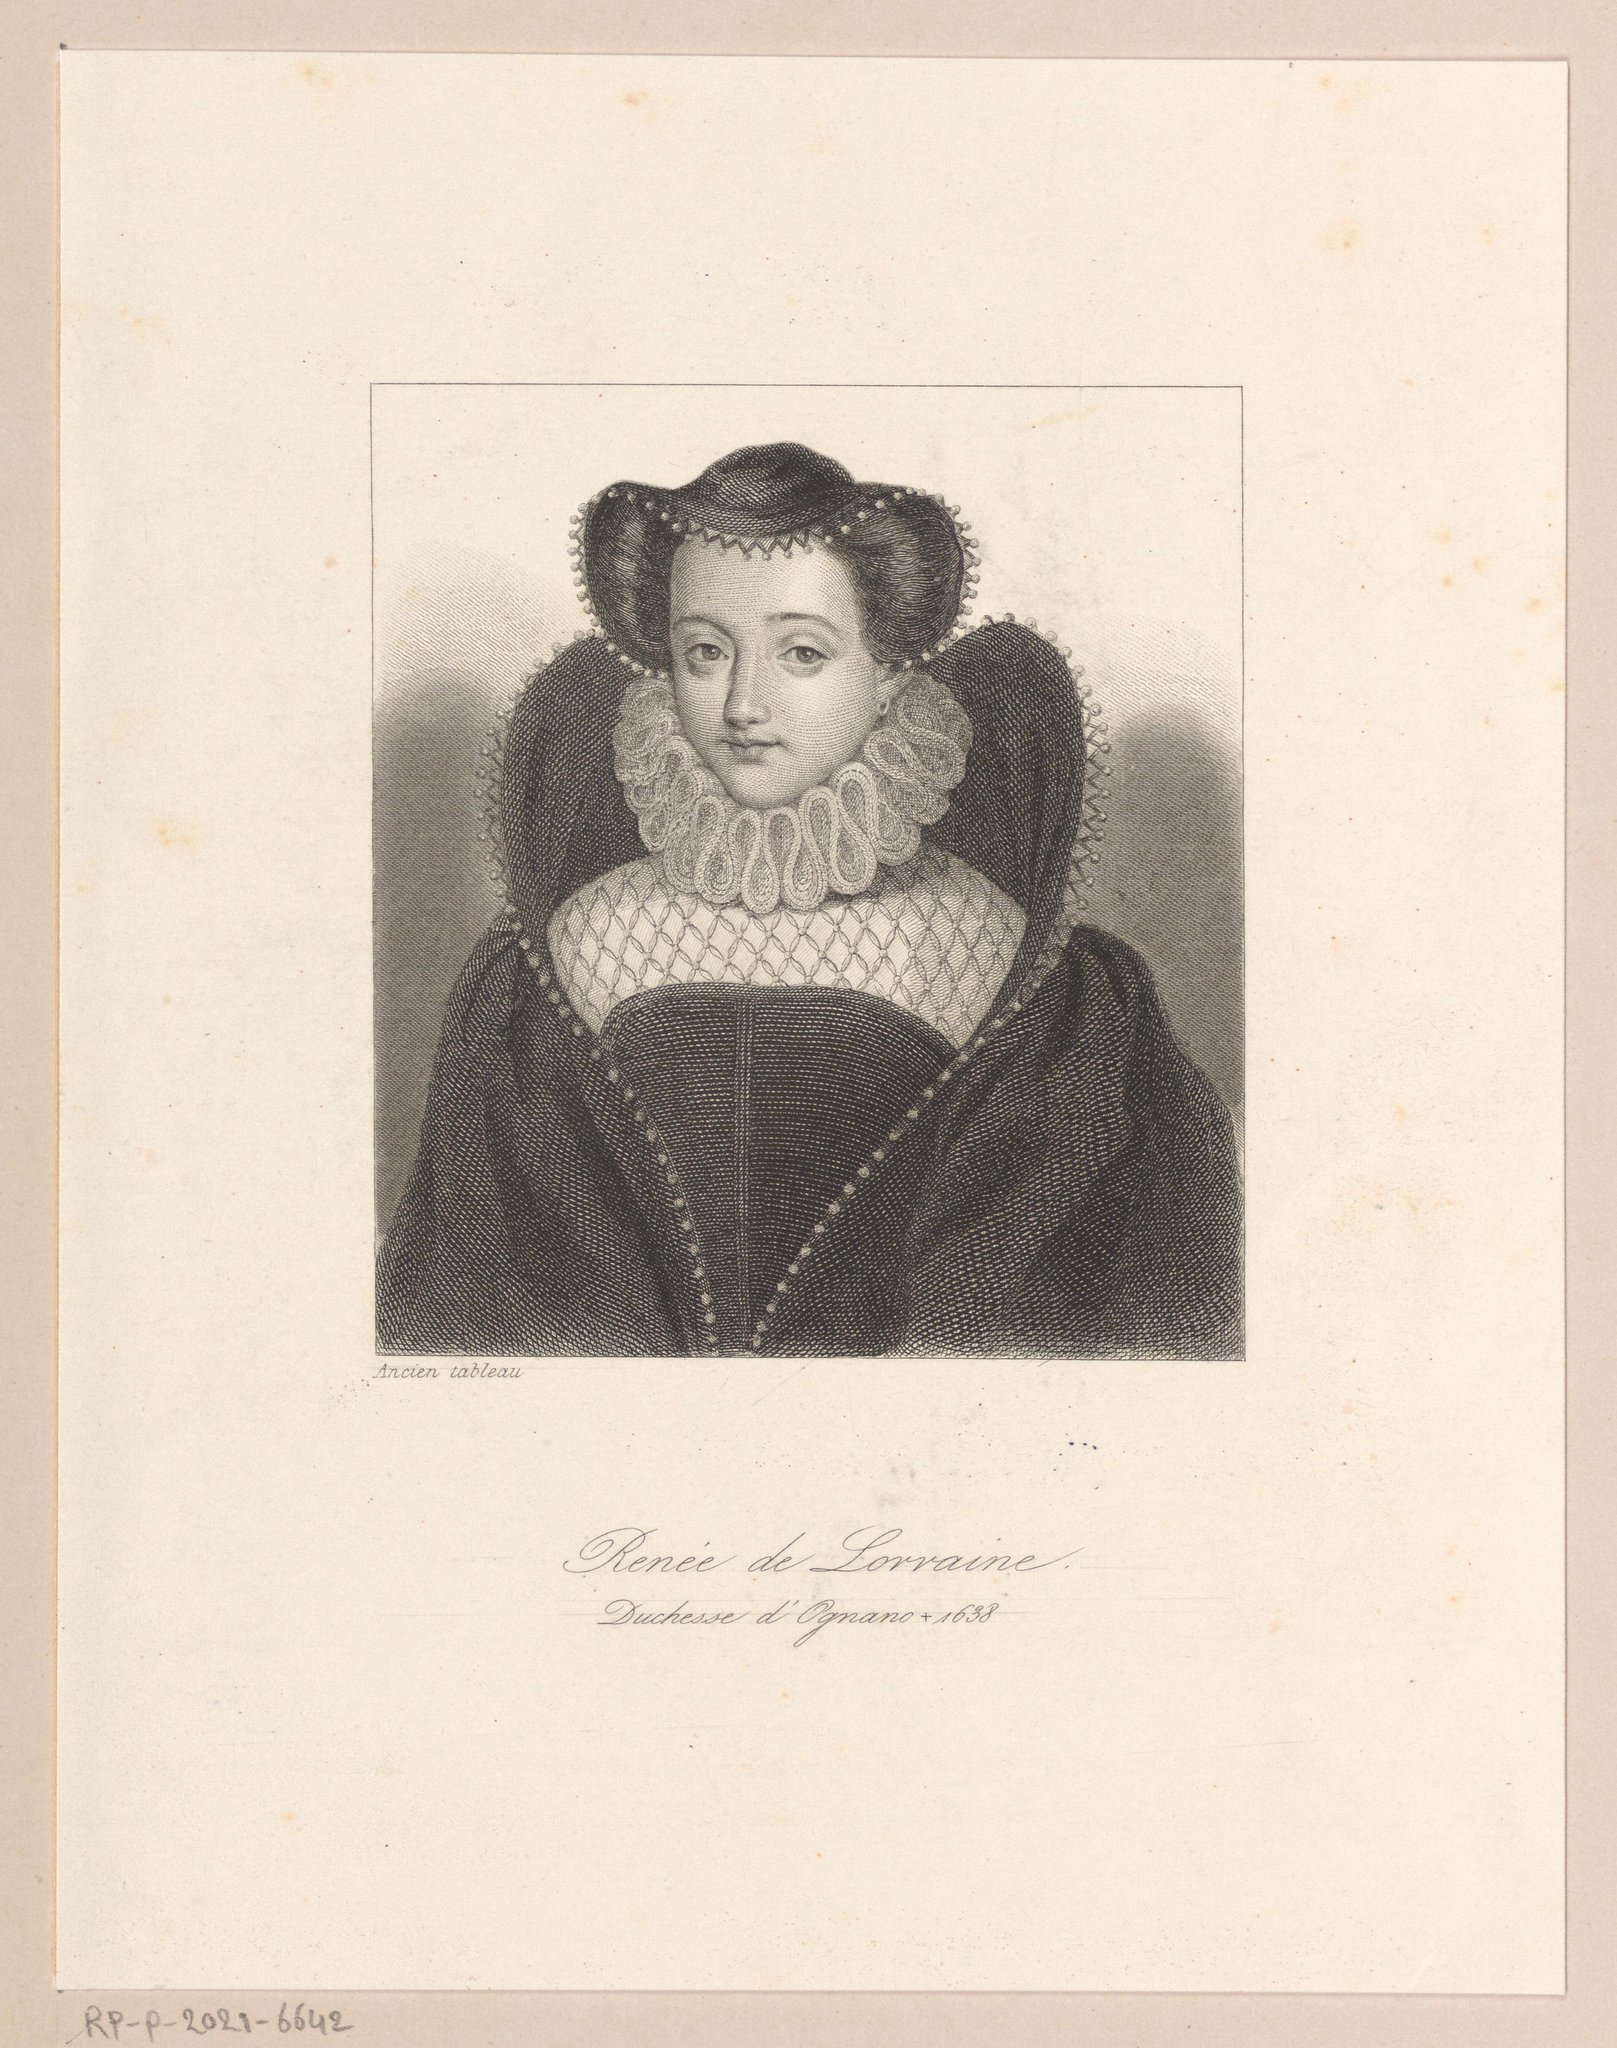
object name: print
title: Oude schilderijen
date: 1804-1871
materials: paper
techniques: engraving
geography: versailles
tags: historical persons - bb - woman